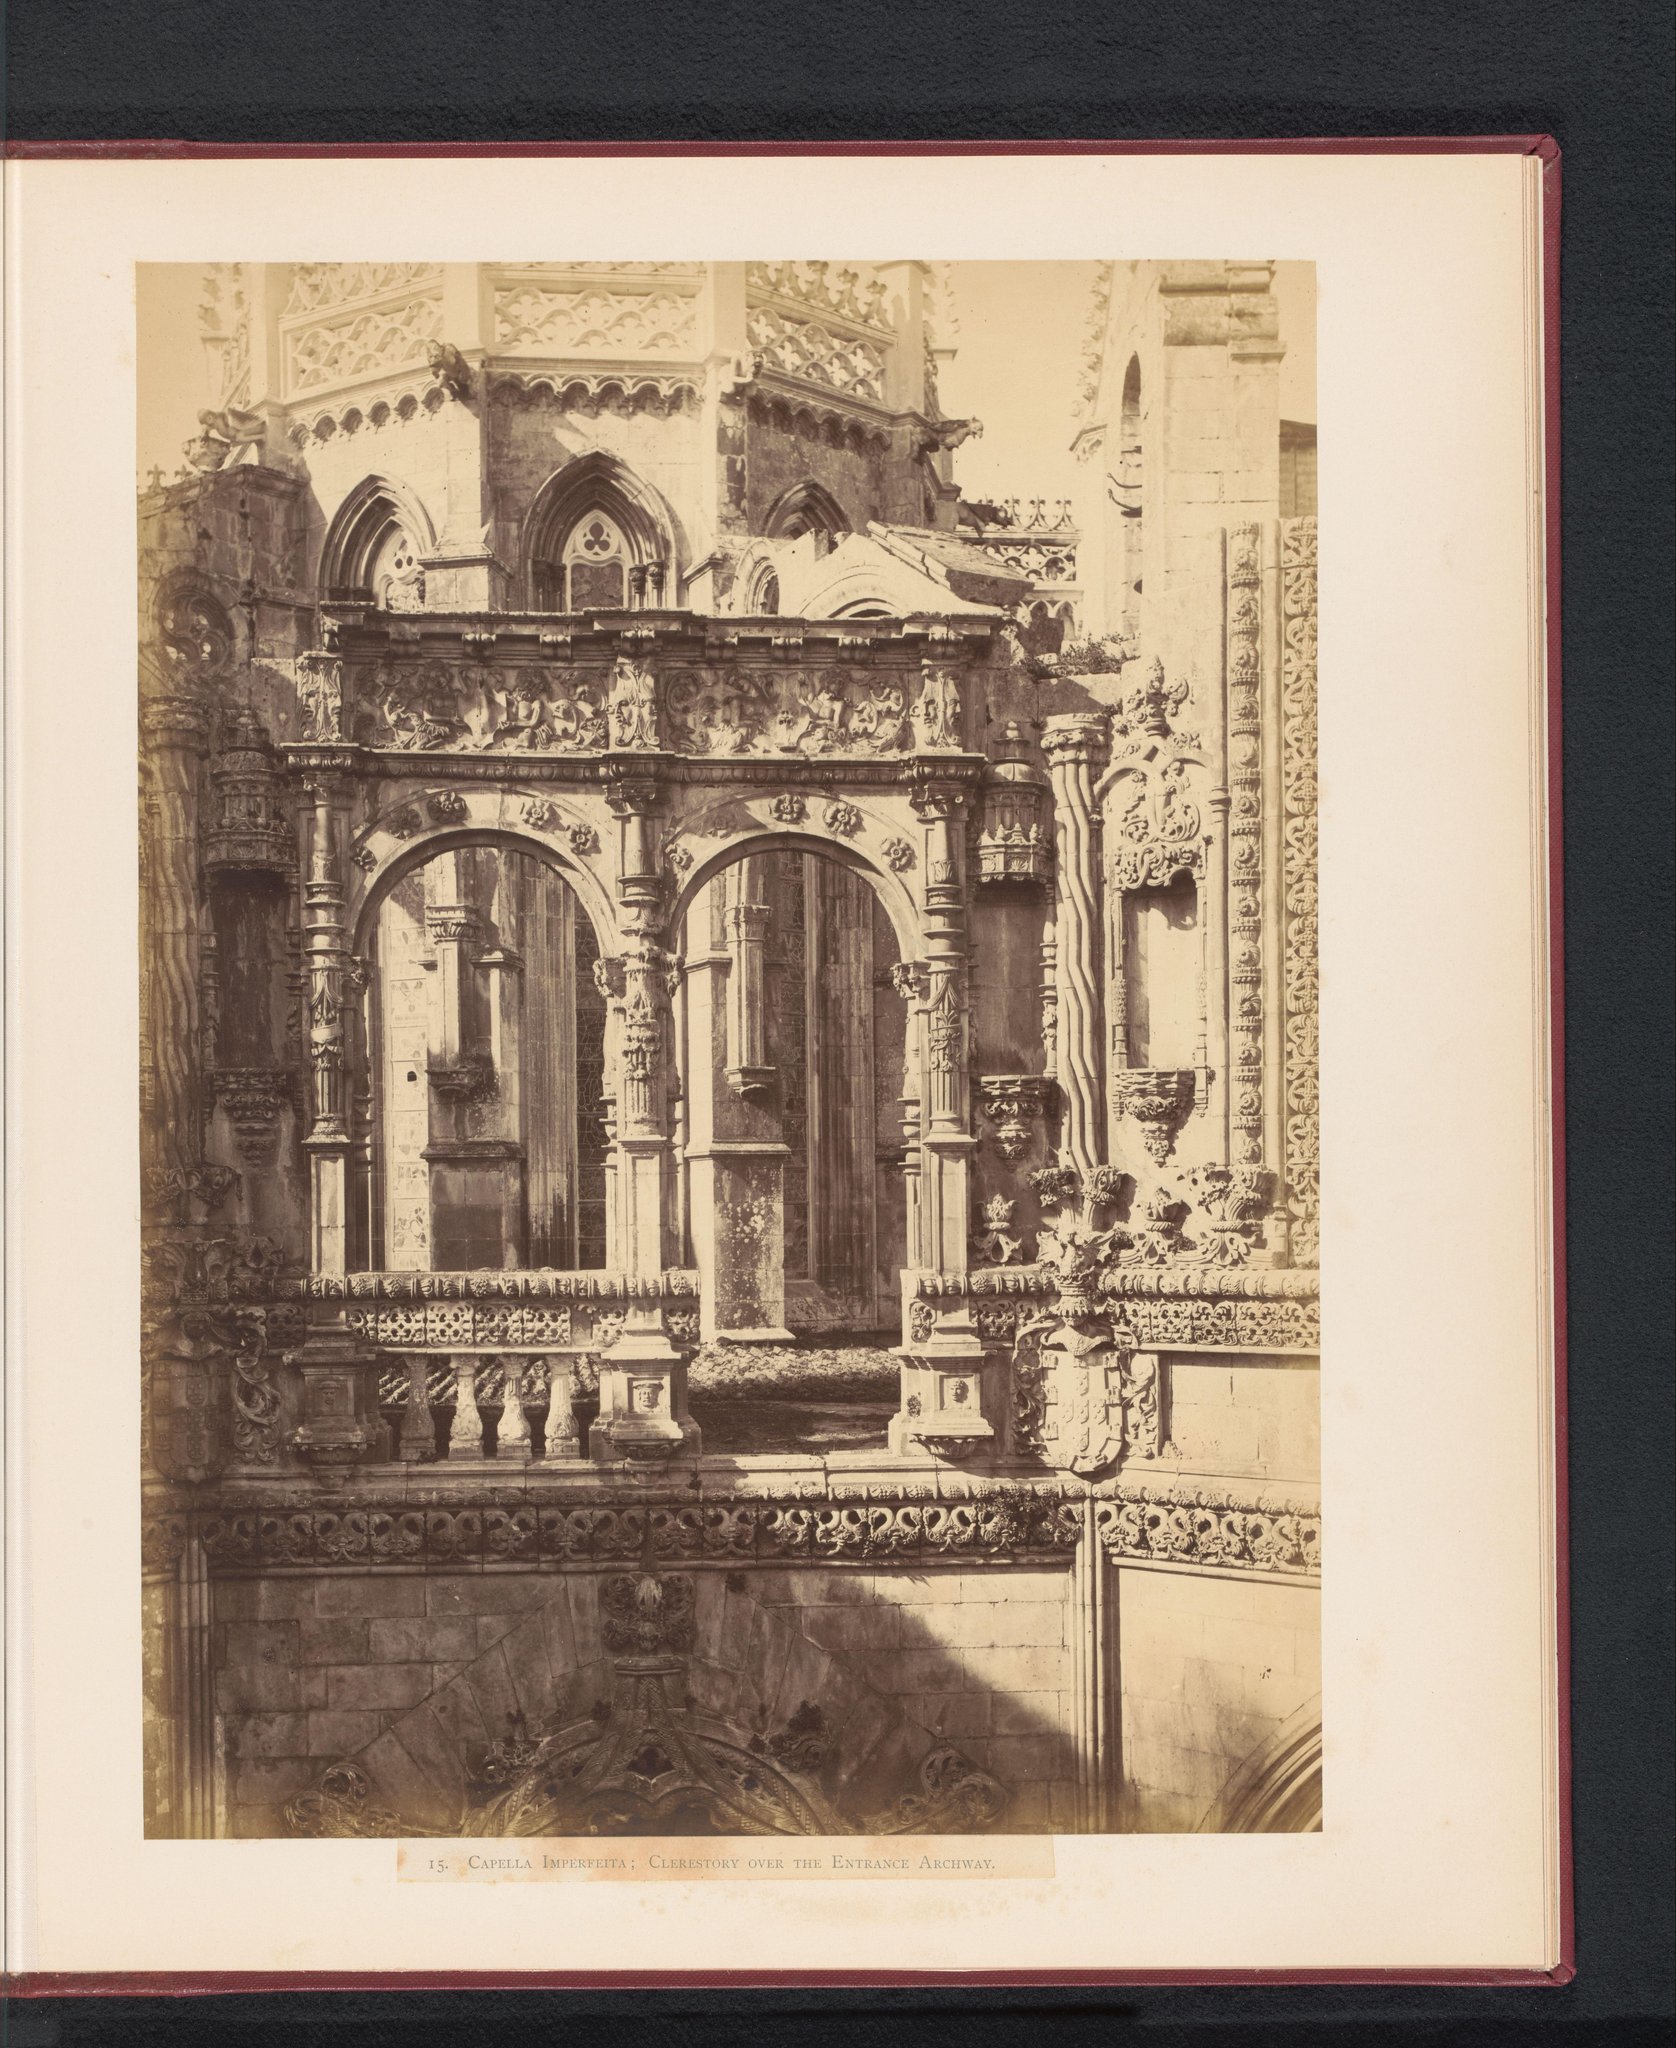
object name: page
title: Gezicht op een detail van de toegangsboog van het klooster van Batalha, Portugal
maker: charles thurston thompson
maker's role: fotograaf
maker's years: 1816-1868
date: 1863-1868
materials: photographic support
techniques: albumen print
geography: batalha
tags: arch, archivolt ~ architecture, cloisters ~ monastery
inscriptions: number: ‘15.’